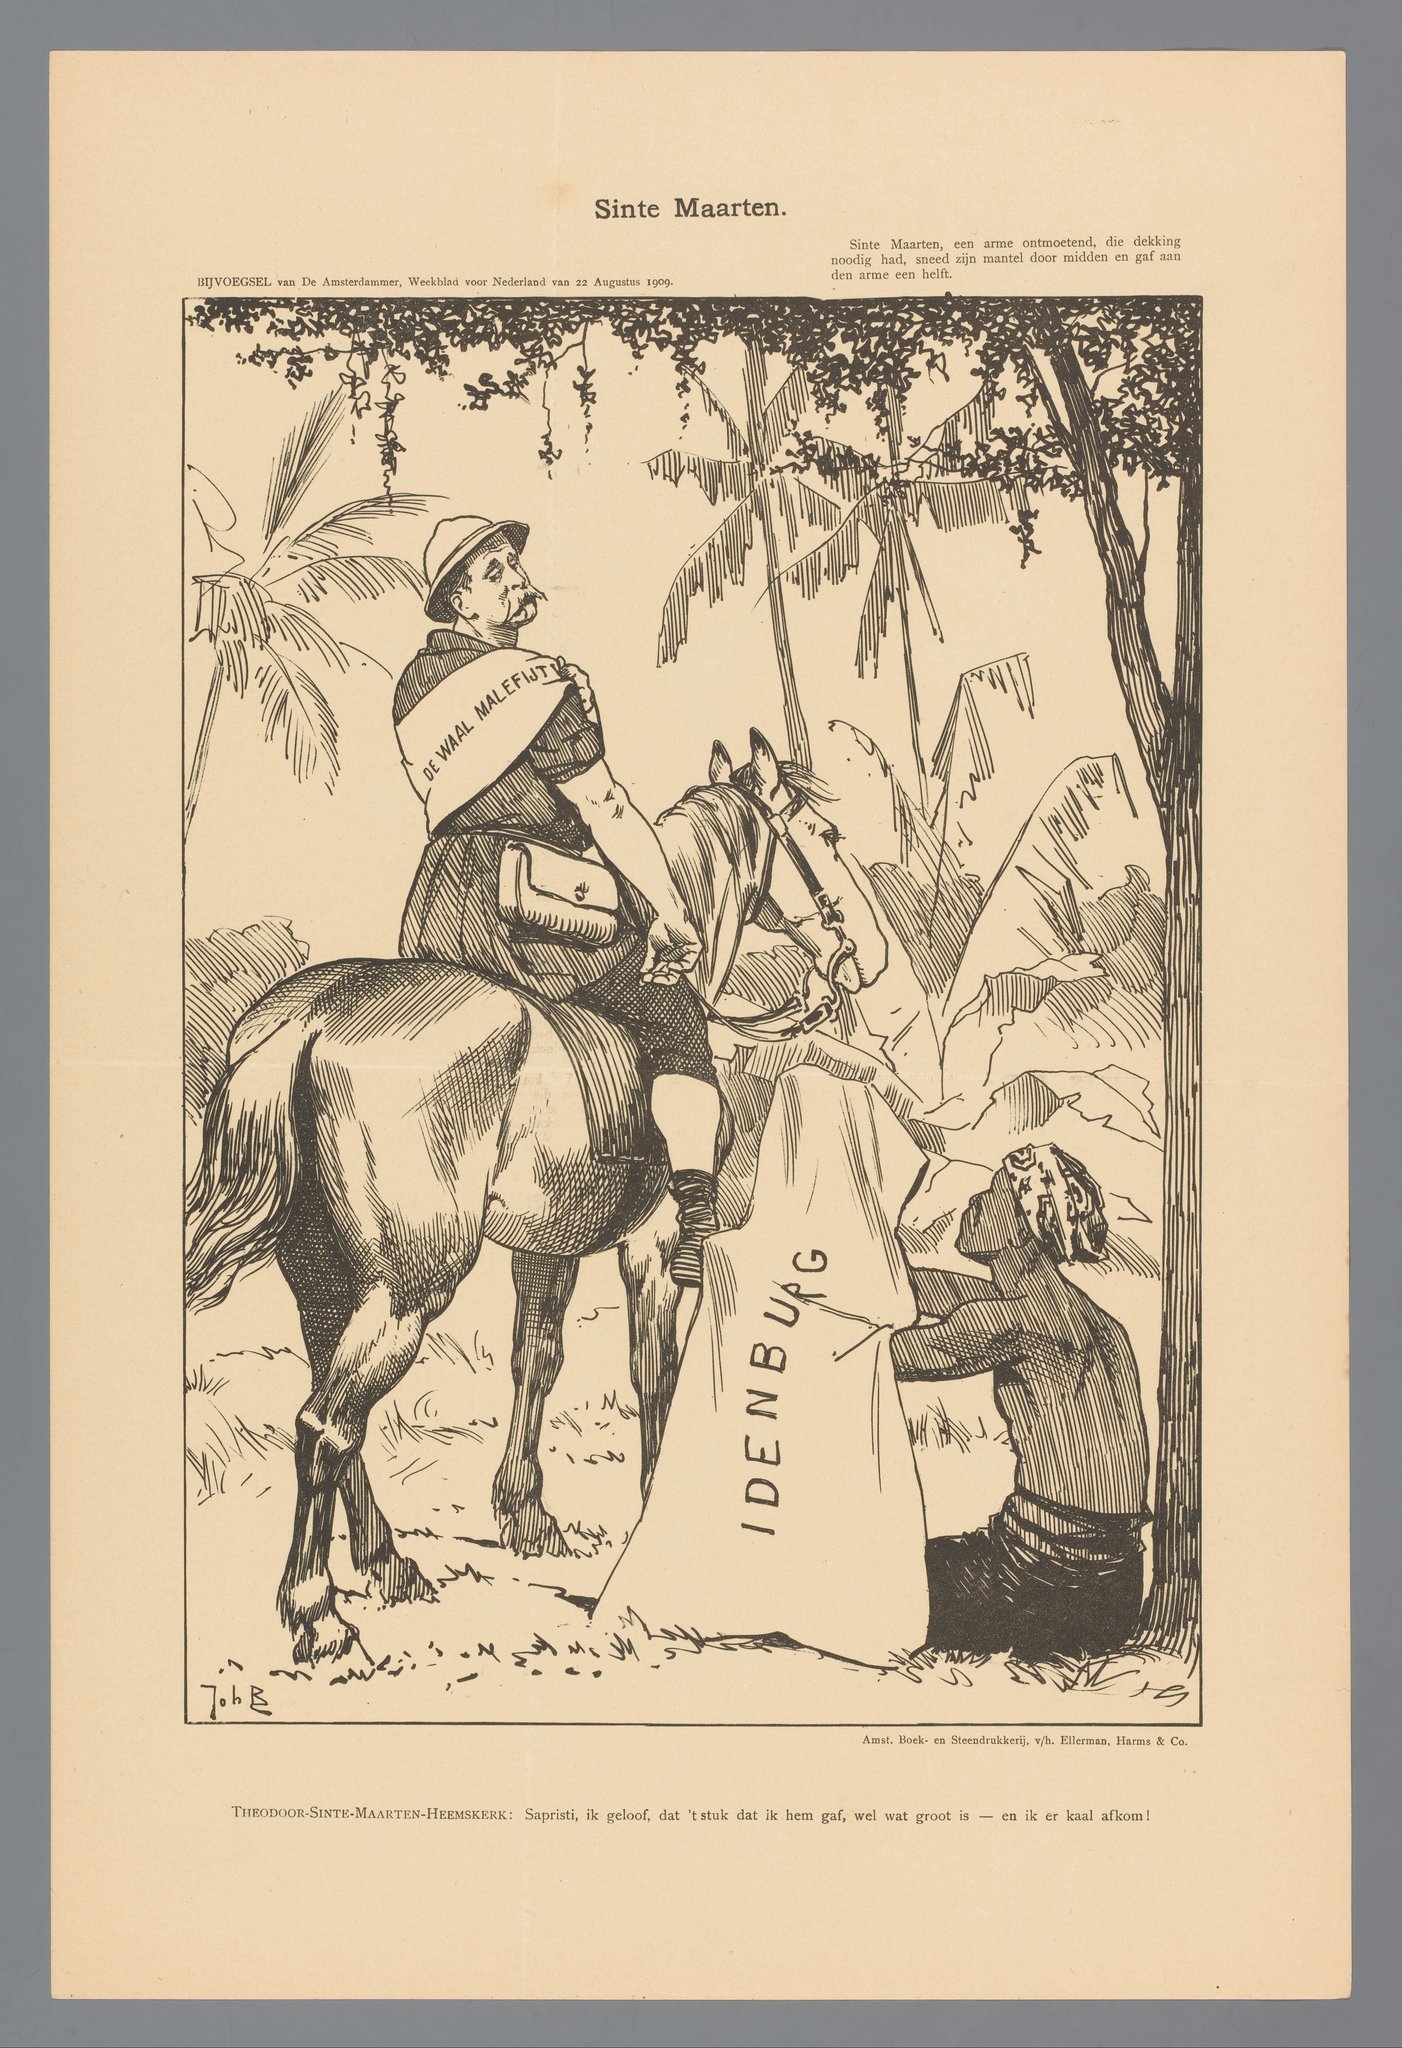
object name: cartoon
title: Sinte Maarten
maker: johan braakensiek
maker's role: draughtsman, print maker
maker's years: 1858-1940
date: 1909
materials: paper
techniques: lithograph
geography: amsterdam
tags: amsterdam, utrecht, st. martin divides his cloak (i.e. the charity of st. martin): he is usually shown on horseback, cutting his cloak with his sword, or putting part of the cloak round the shoulders of a beggar who kneels beside him, historical persons, political caricatures and satires, dutch east indies, the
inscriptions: date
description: Prent uit het bijvoegsel van: De Amsterdammer. Weekblad voor Nederland, 22 augustus 1909.